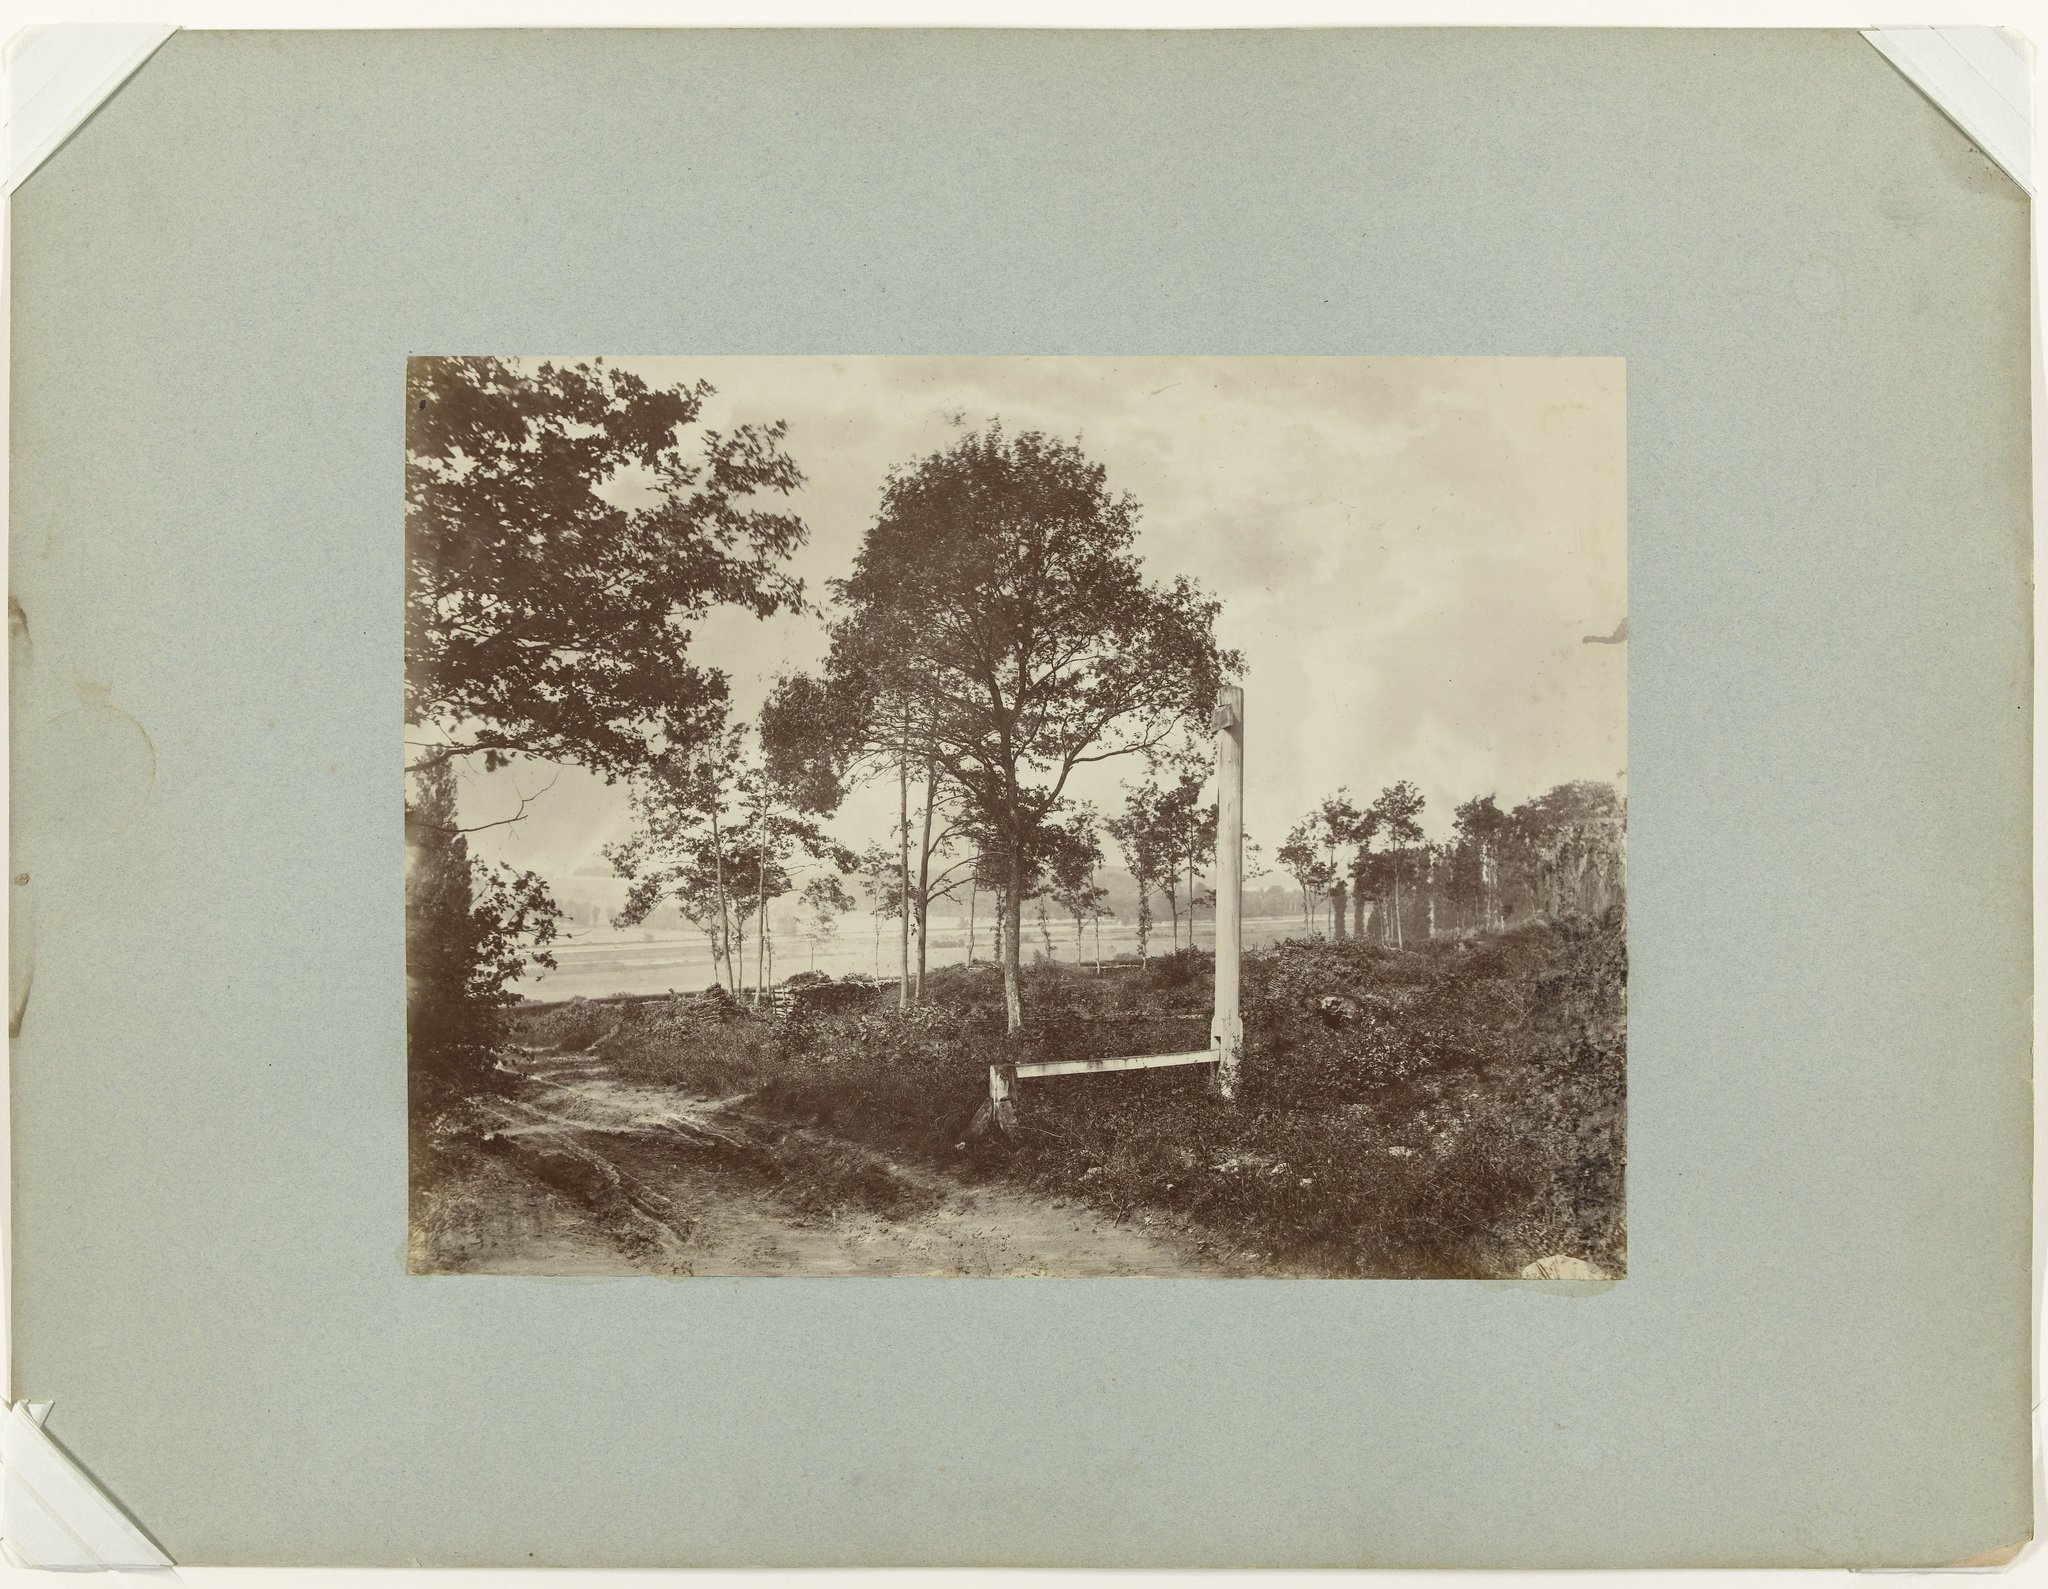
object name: photograph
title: Landschap met bomen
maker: Anonymous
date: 1870-1890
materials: cardboard, photographic support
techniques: albumen print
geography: france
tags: landscapes in the temperate zone